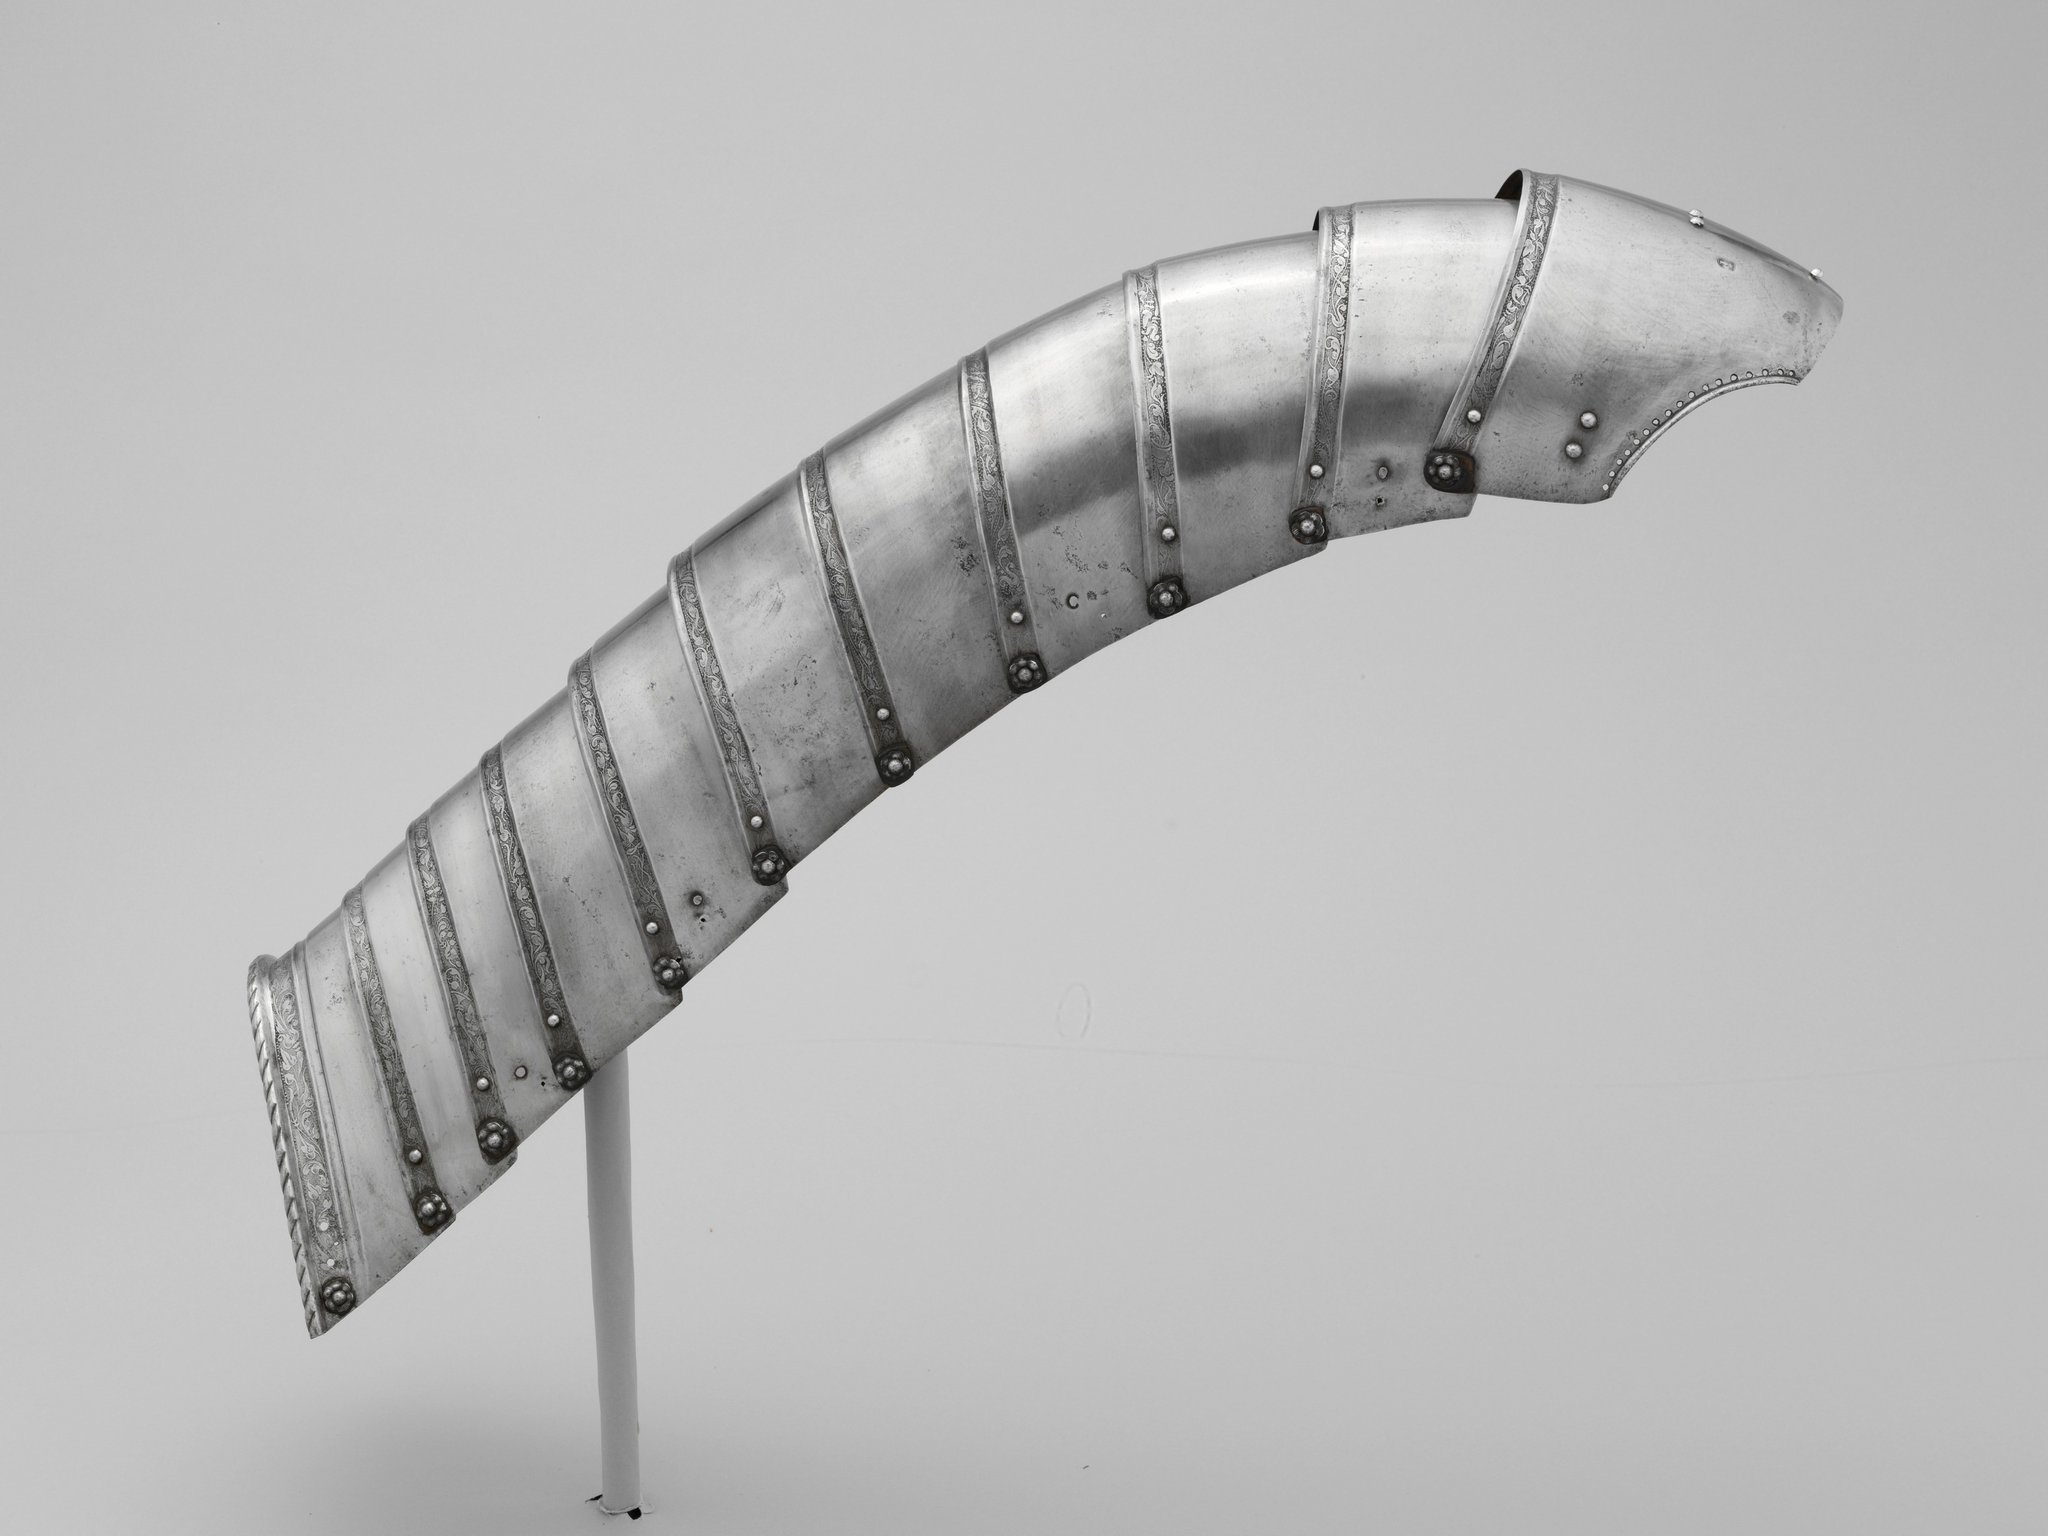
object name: crinet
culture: german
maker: valentin siebenbürger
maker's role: armorer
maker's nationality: german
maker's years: 1485-1564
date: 1535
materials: steel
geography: germany